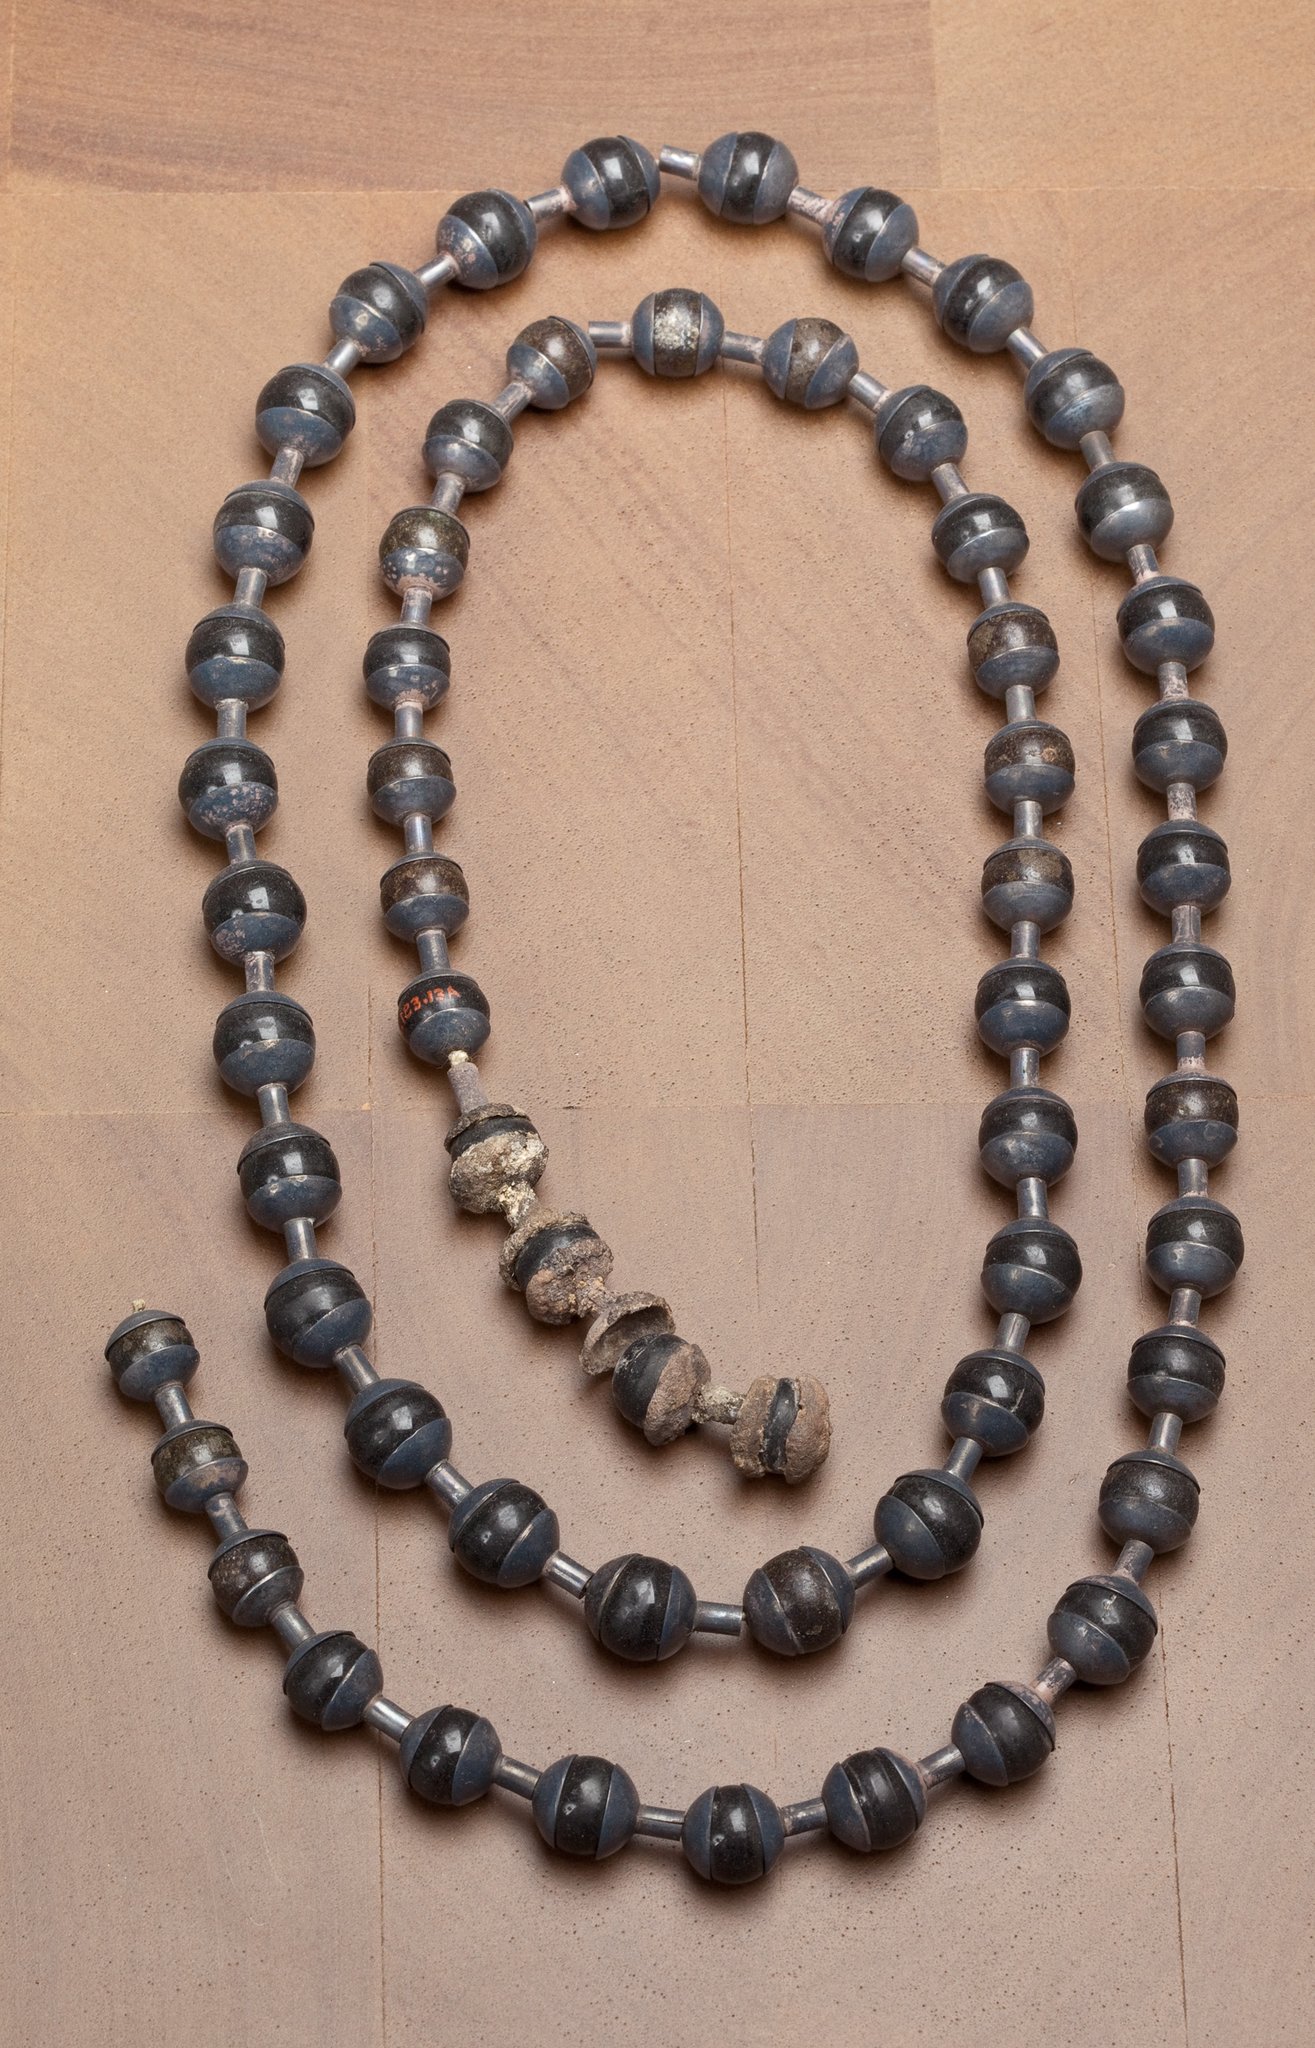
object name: necklace, hapiankhtifi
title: Necklace of Hapiankhtifi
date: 1981-1802 BCE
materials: obsidian, silver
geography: egypt